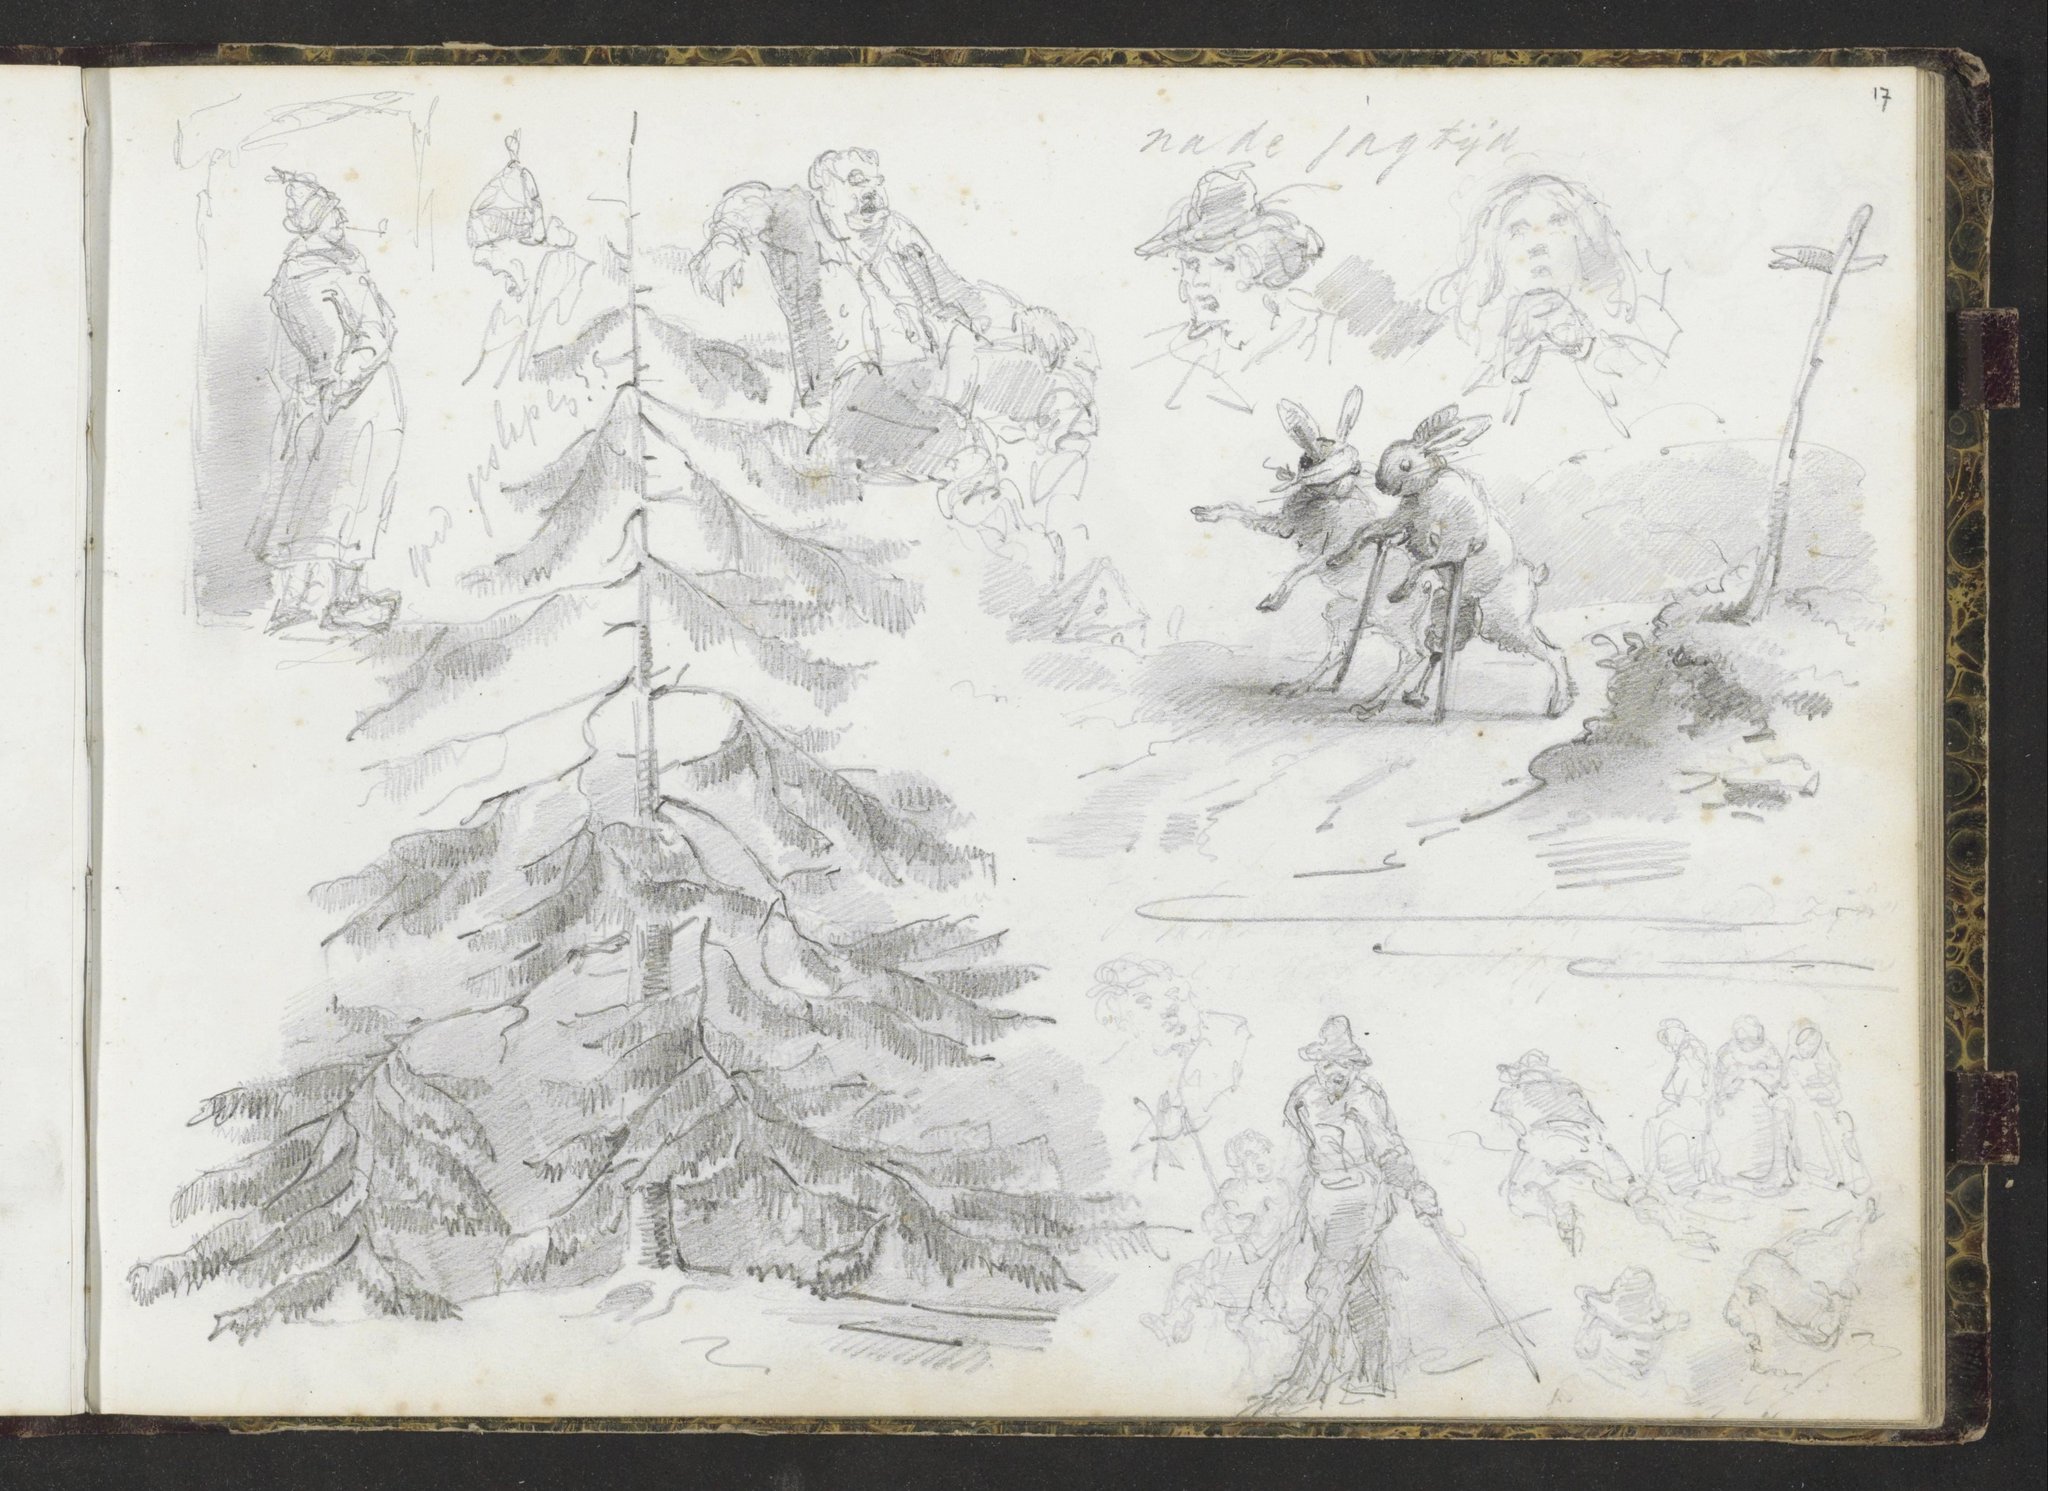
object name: sketchbook leaf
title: Studieblad met bomen, figuren en karikaturale scènes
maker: lambertus lingeman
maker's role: draughtsman, painter, print maker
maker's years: 1829-1894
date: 1839-1894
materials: paper, pencil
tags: trees, nightwear: night-cap (+ men's clothes), rodents: hare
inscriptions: annotation: ‘goed geslapen??/ na de jagtijd/ [...] zijn’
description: Onder andere een studie van twee hazen, één met krukken en één met verband om de kop, op een bospad en van twee mannen met slaapmutsen. Blad 17 recto uit een schetsboek met 51 bladen.